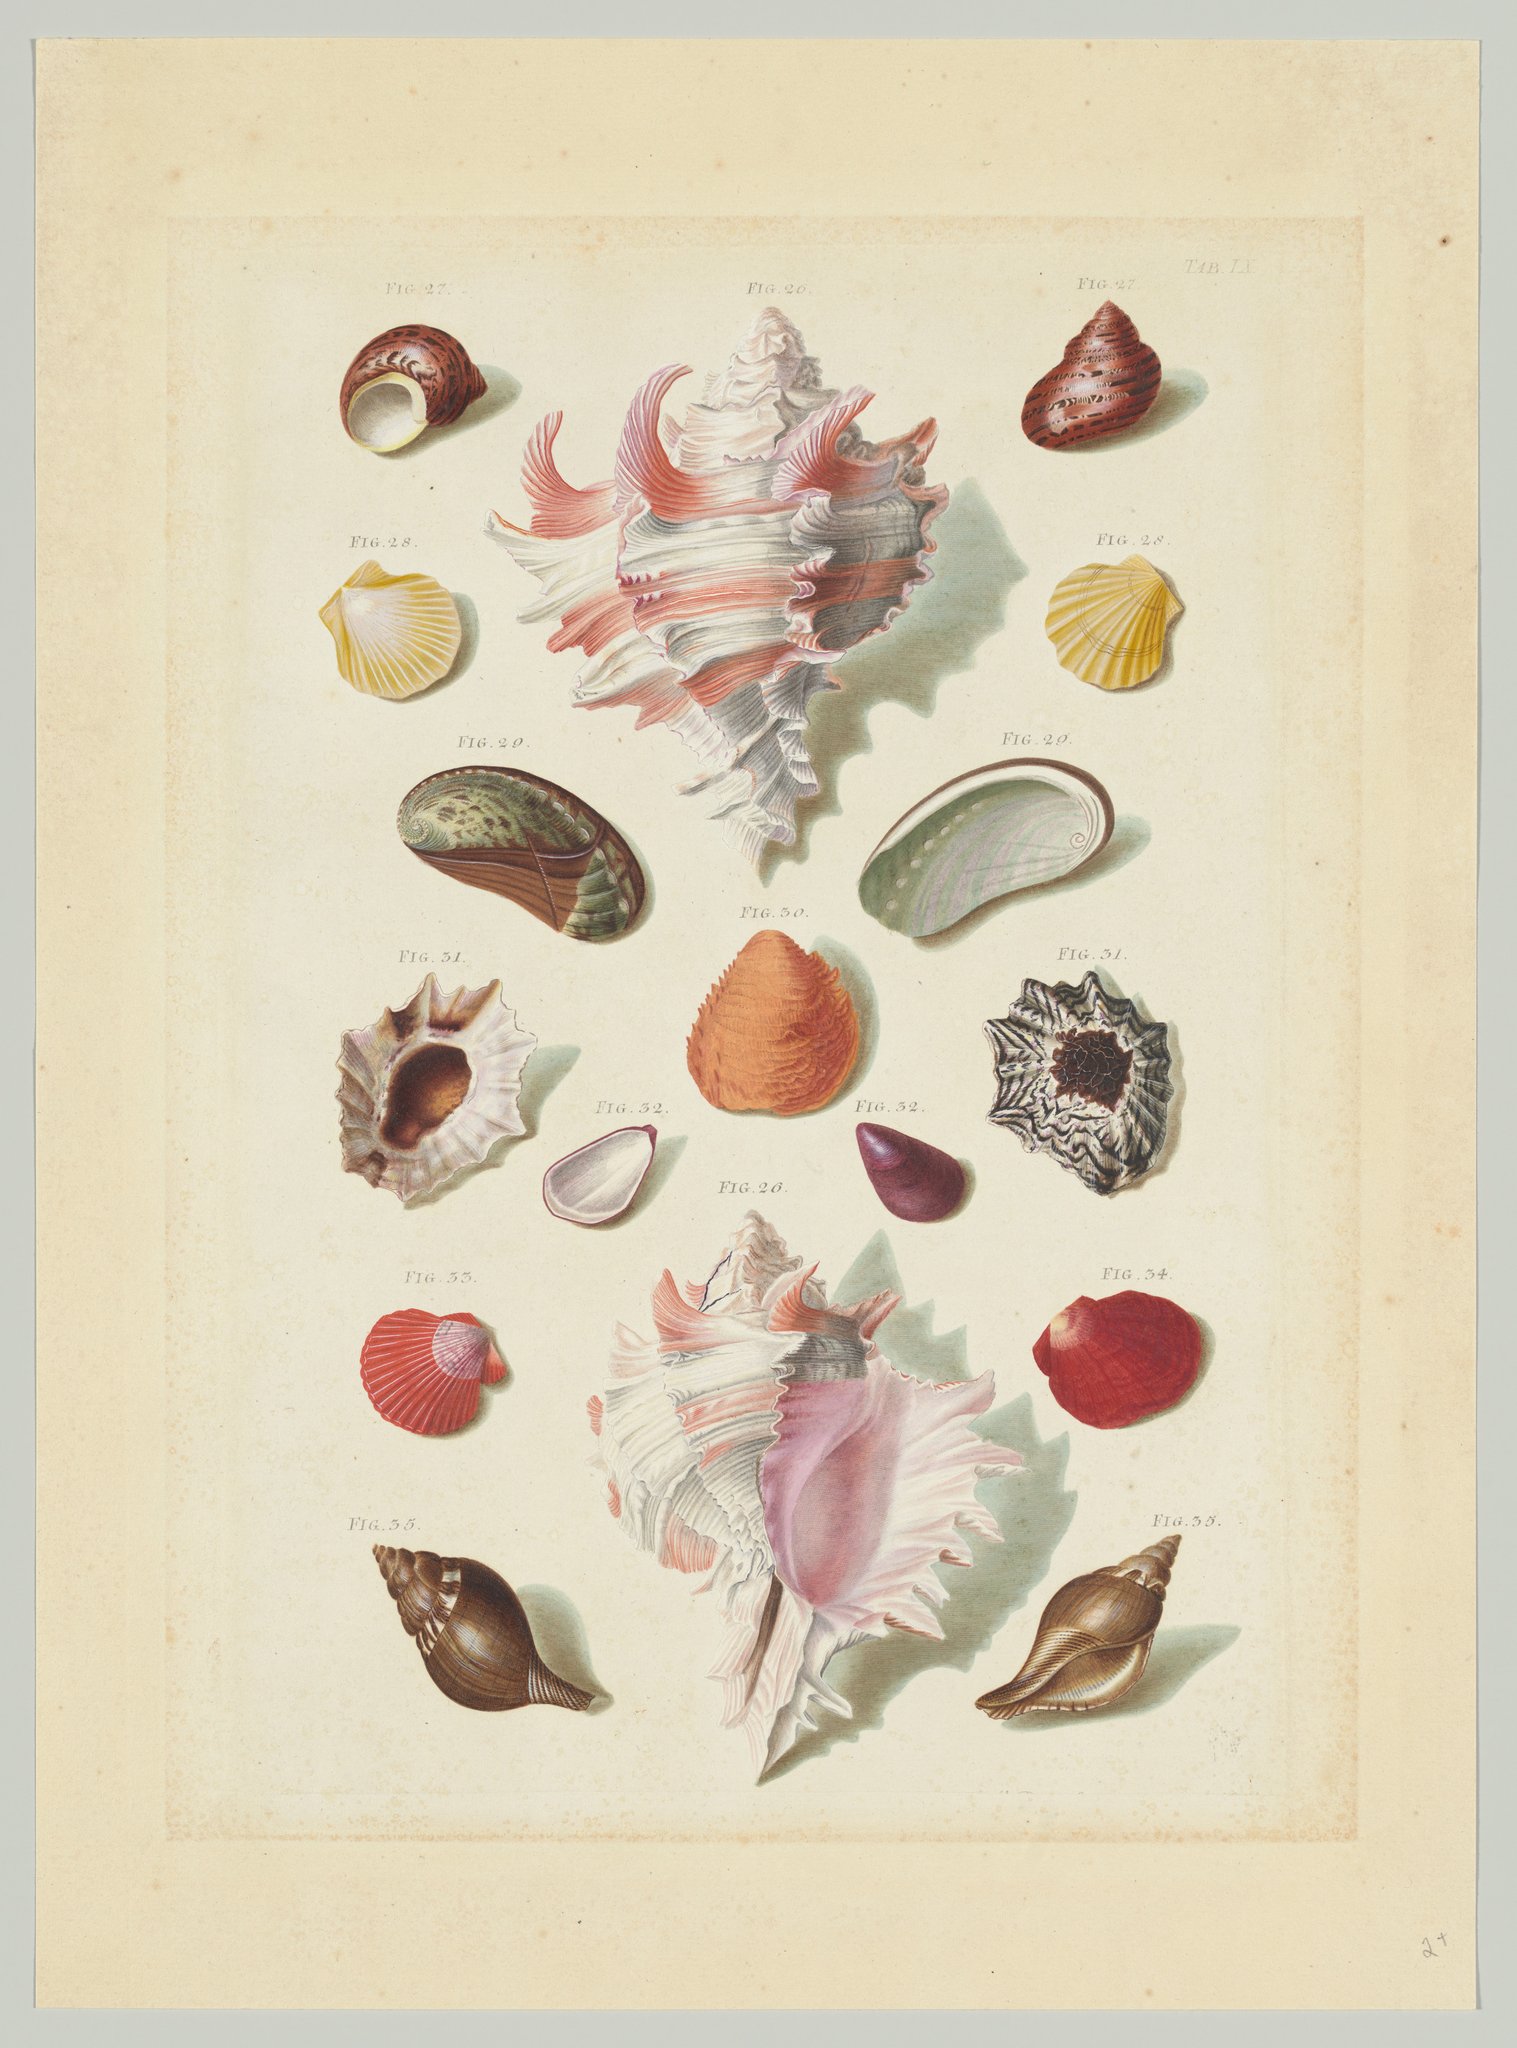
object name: print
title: Plate IX, from "Choix de Coquillages et de Crustacés"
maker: franz michael regenfuss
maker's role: artist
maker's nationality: german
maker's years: 1707-1780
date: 1758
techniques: engraving, hand coloring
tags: shells